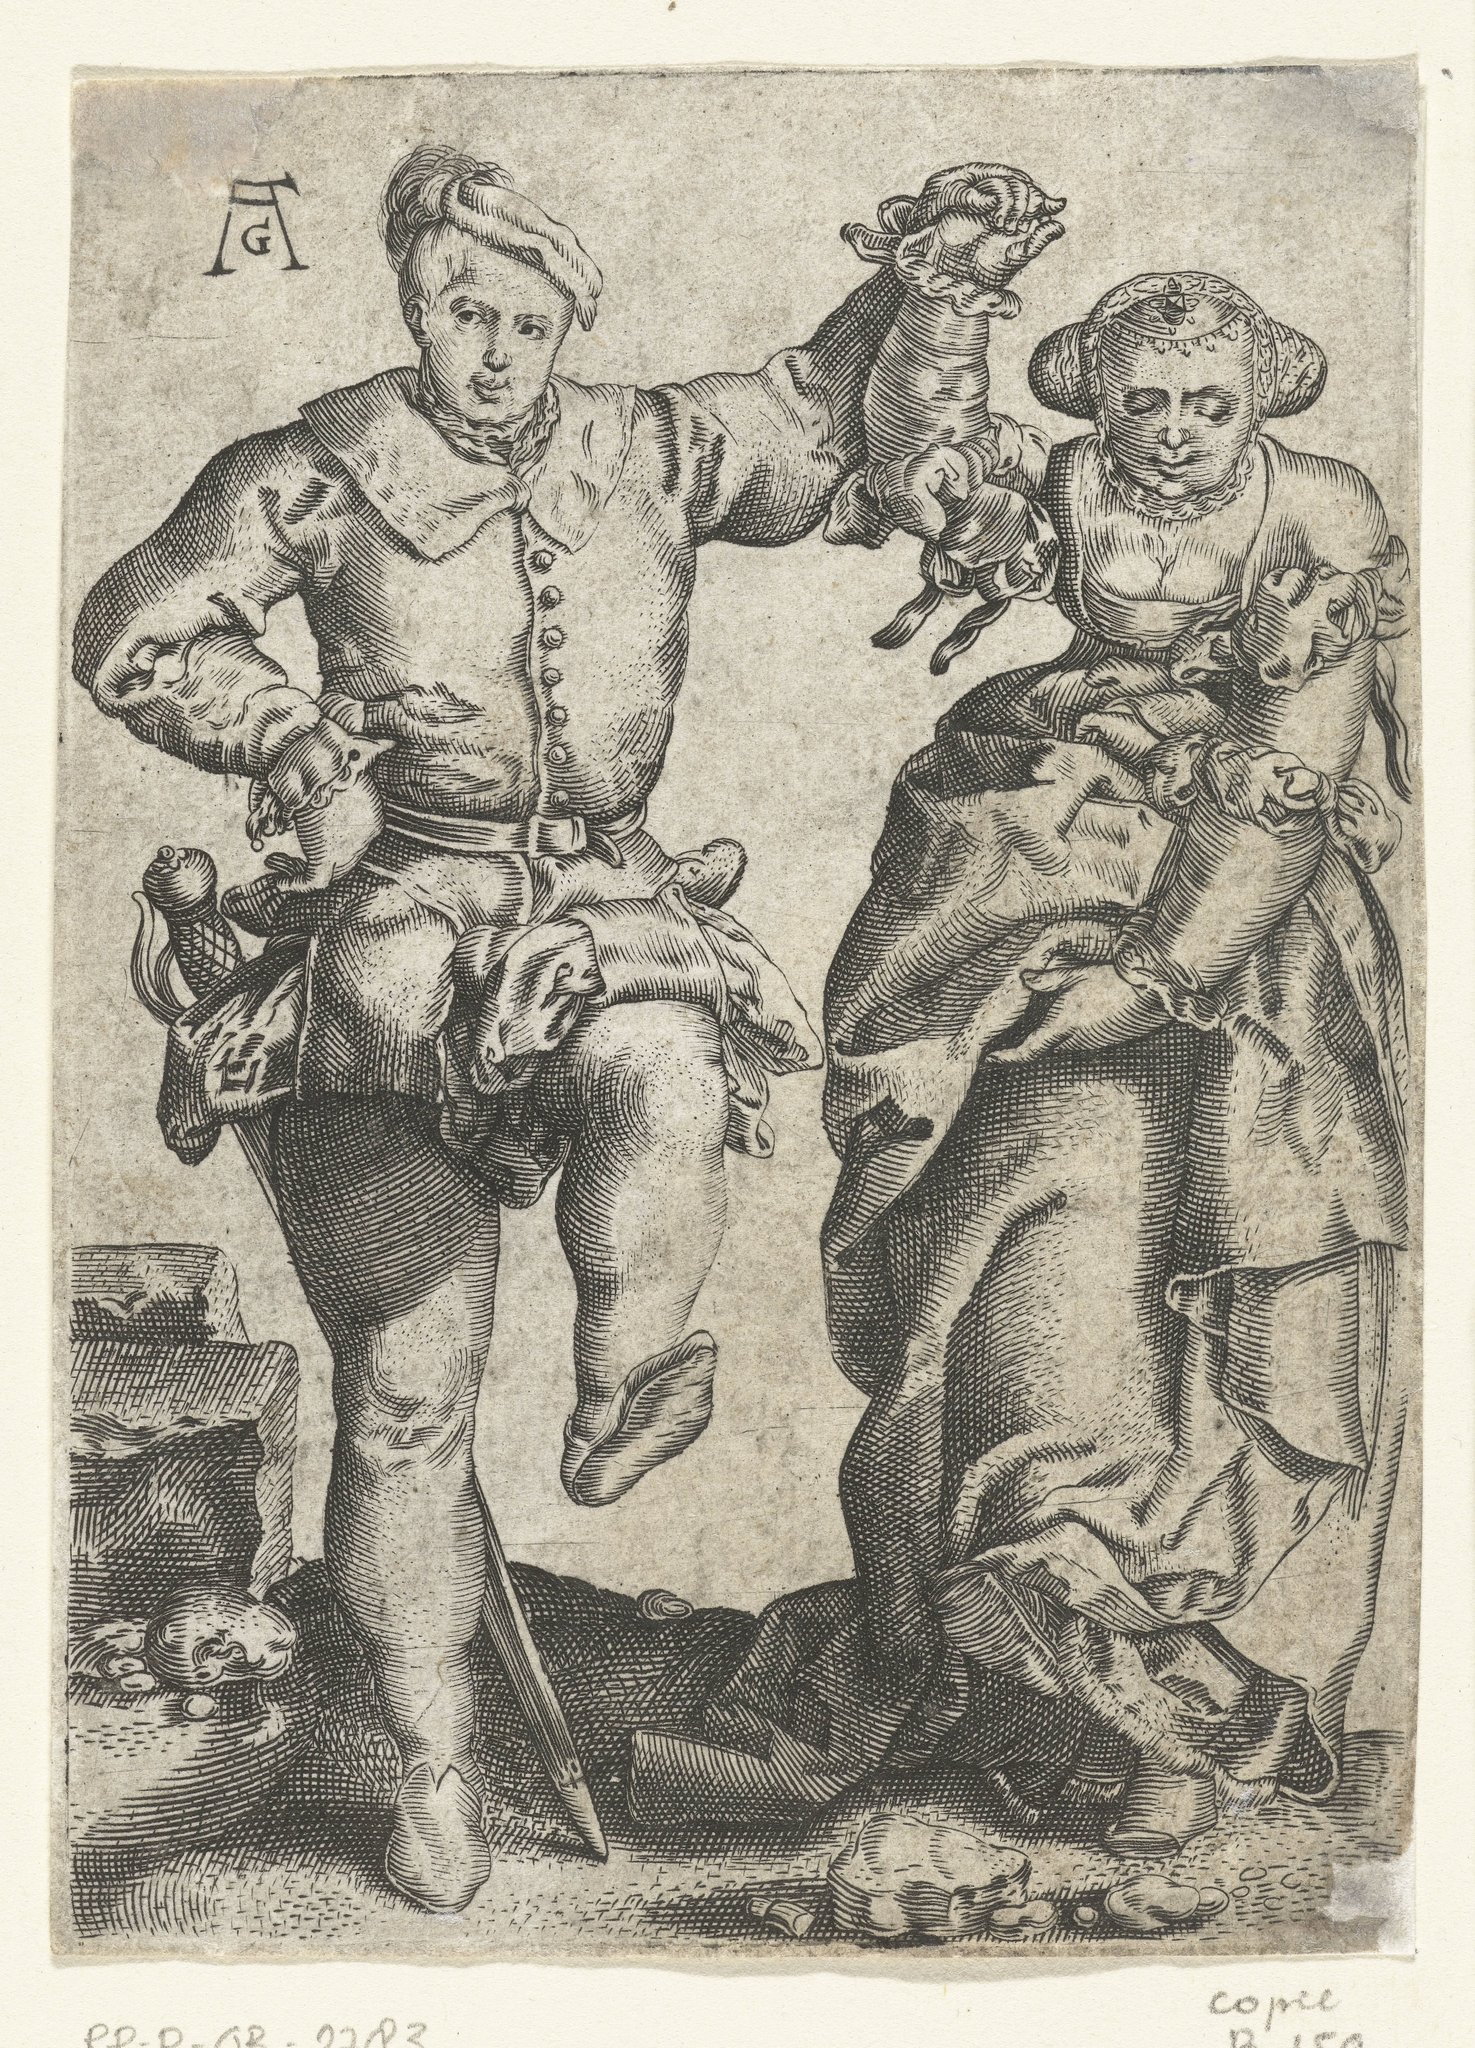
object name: print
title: Dansende paar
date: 1551-1610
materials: paper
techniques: engraving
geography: germany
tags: dancing at wedding feast, one pair dancing; man and woman dancing as a couple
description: Man en vrouw dansend, hand in hand, met de armen omhoog. Beide een voet van de grond. Uit een serie van acht spiegelbeeldige kopieën naar prenten van Aldegrever.